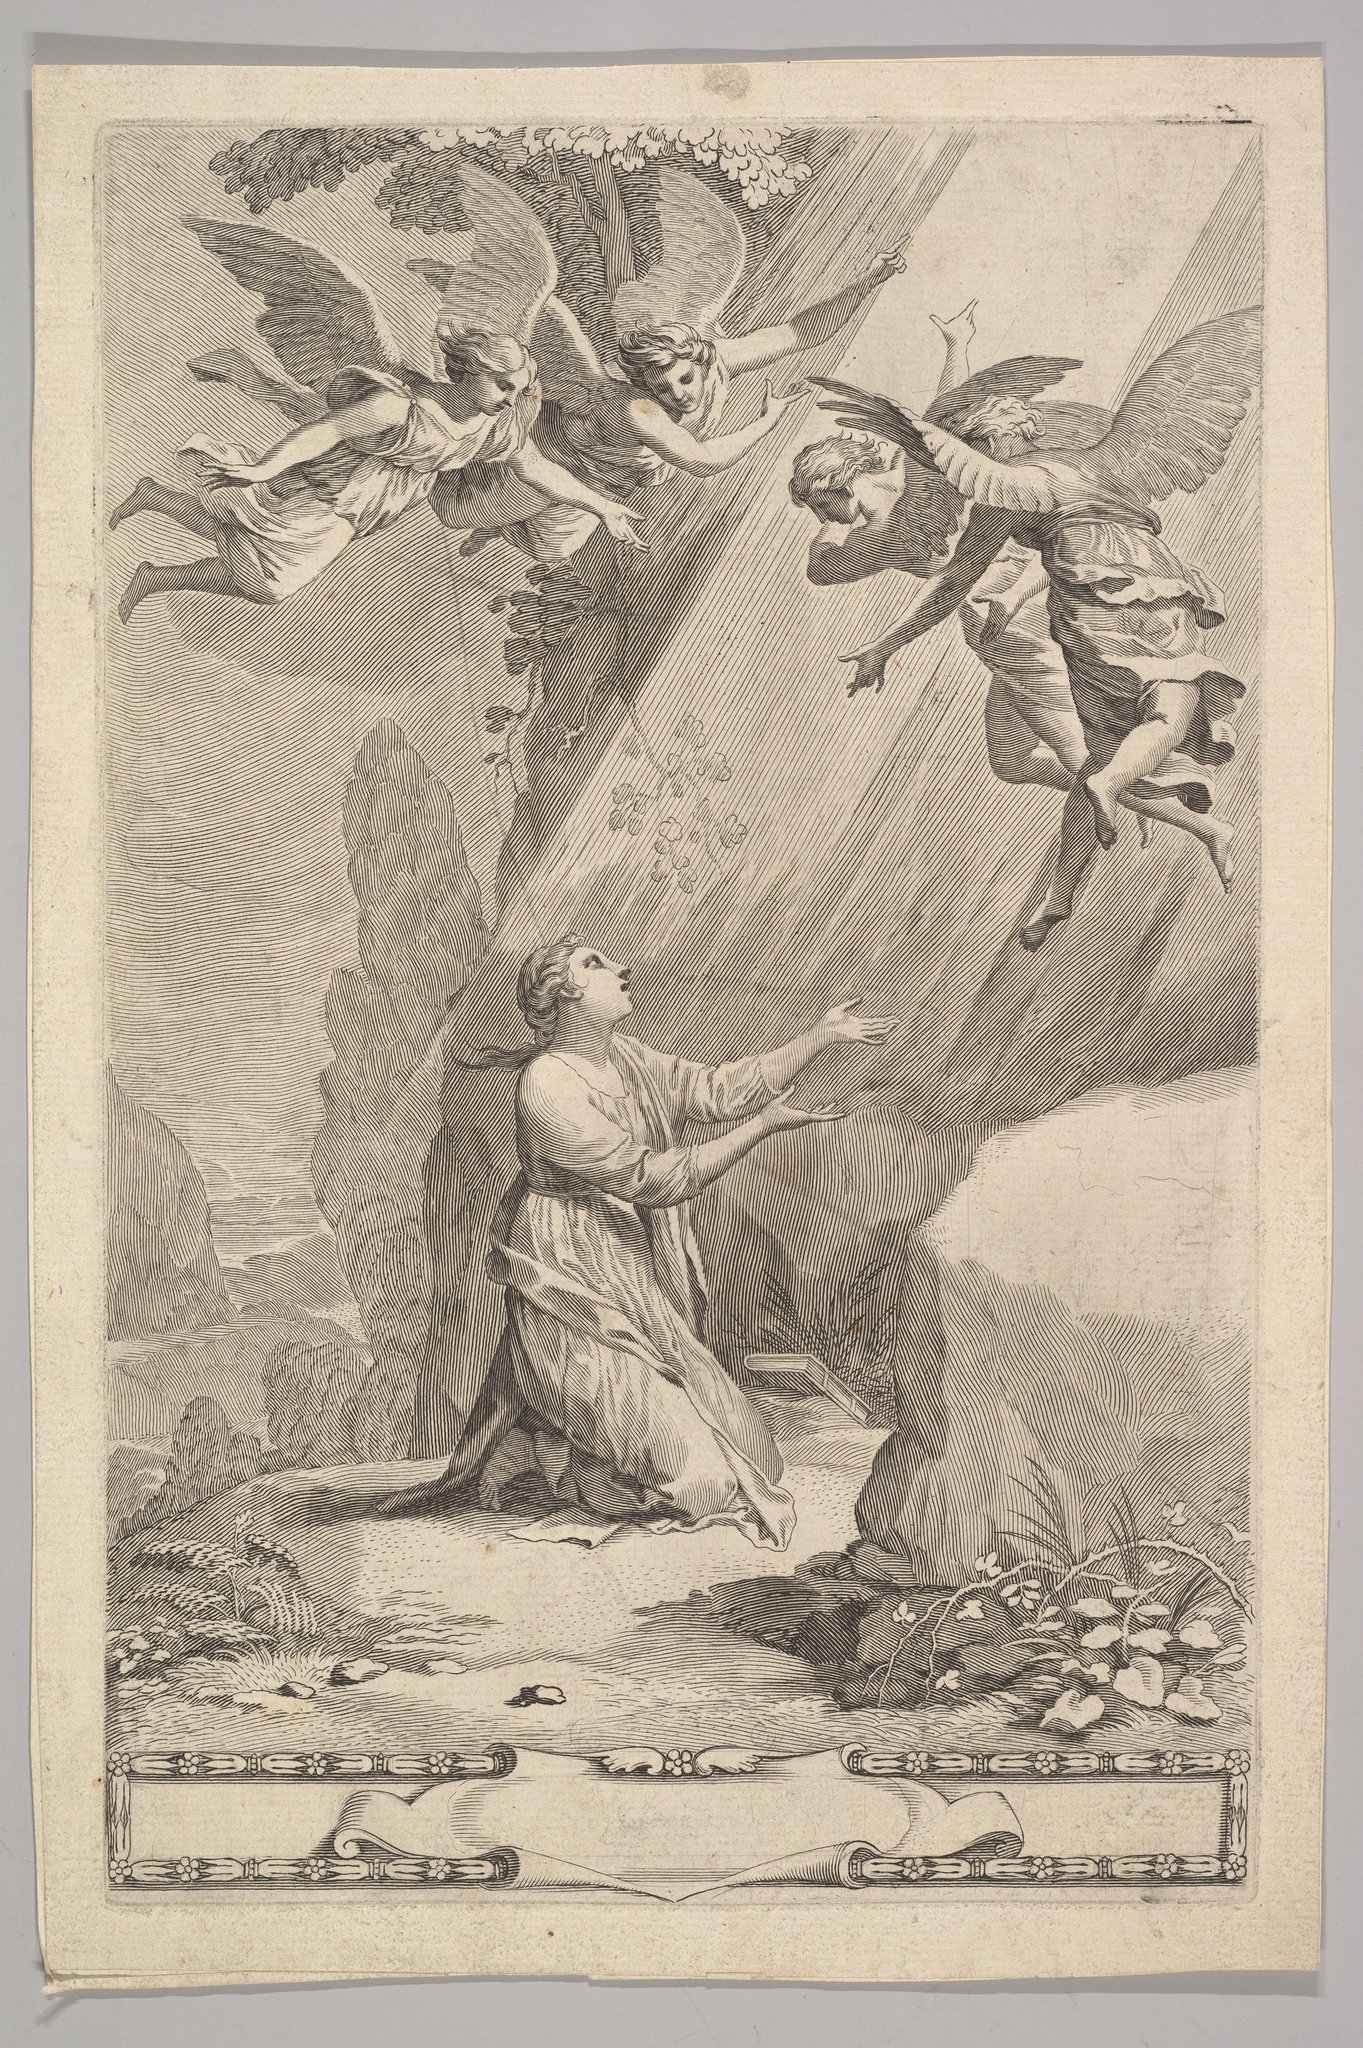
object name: print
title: Title page for François de Sales, Introduction à la vie dévote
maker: claude mellan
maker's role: artist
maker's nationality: french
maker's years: 1598-1688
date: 1641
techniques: etching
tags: men,bishops